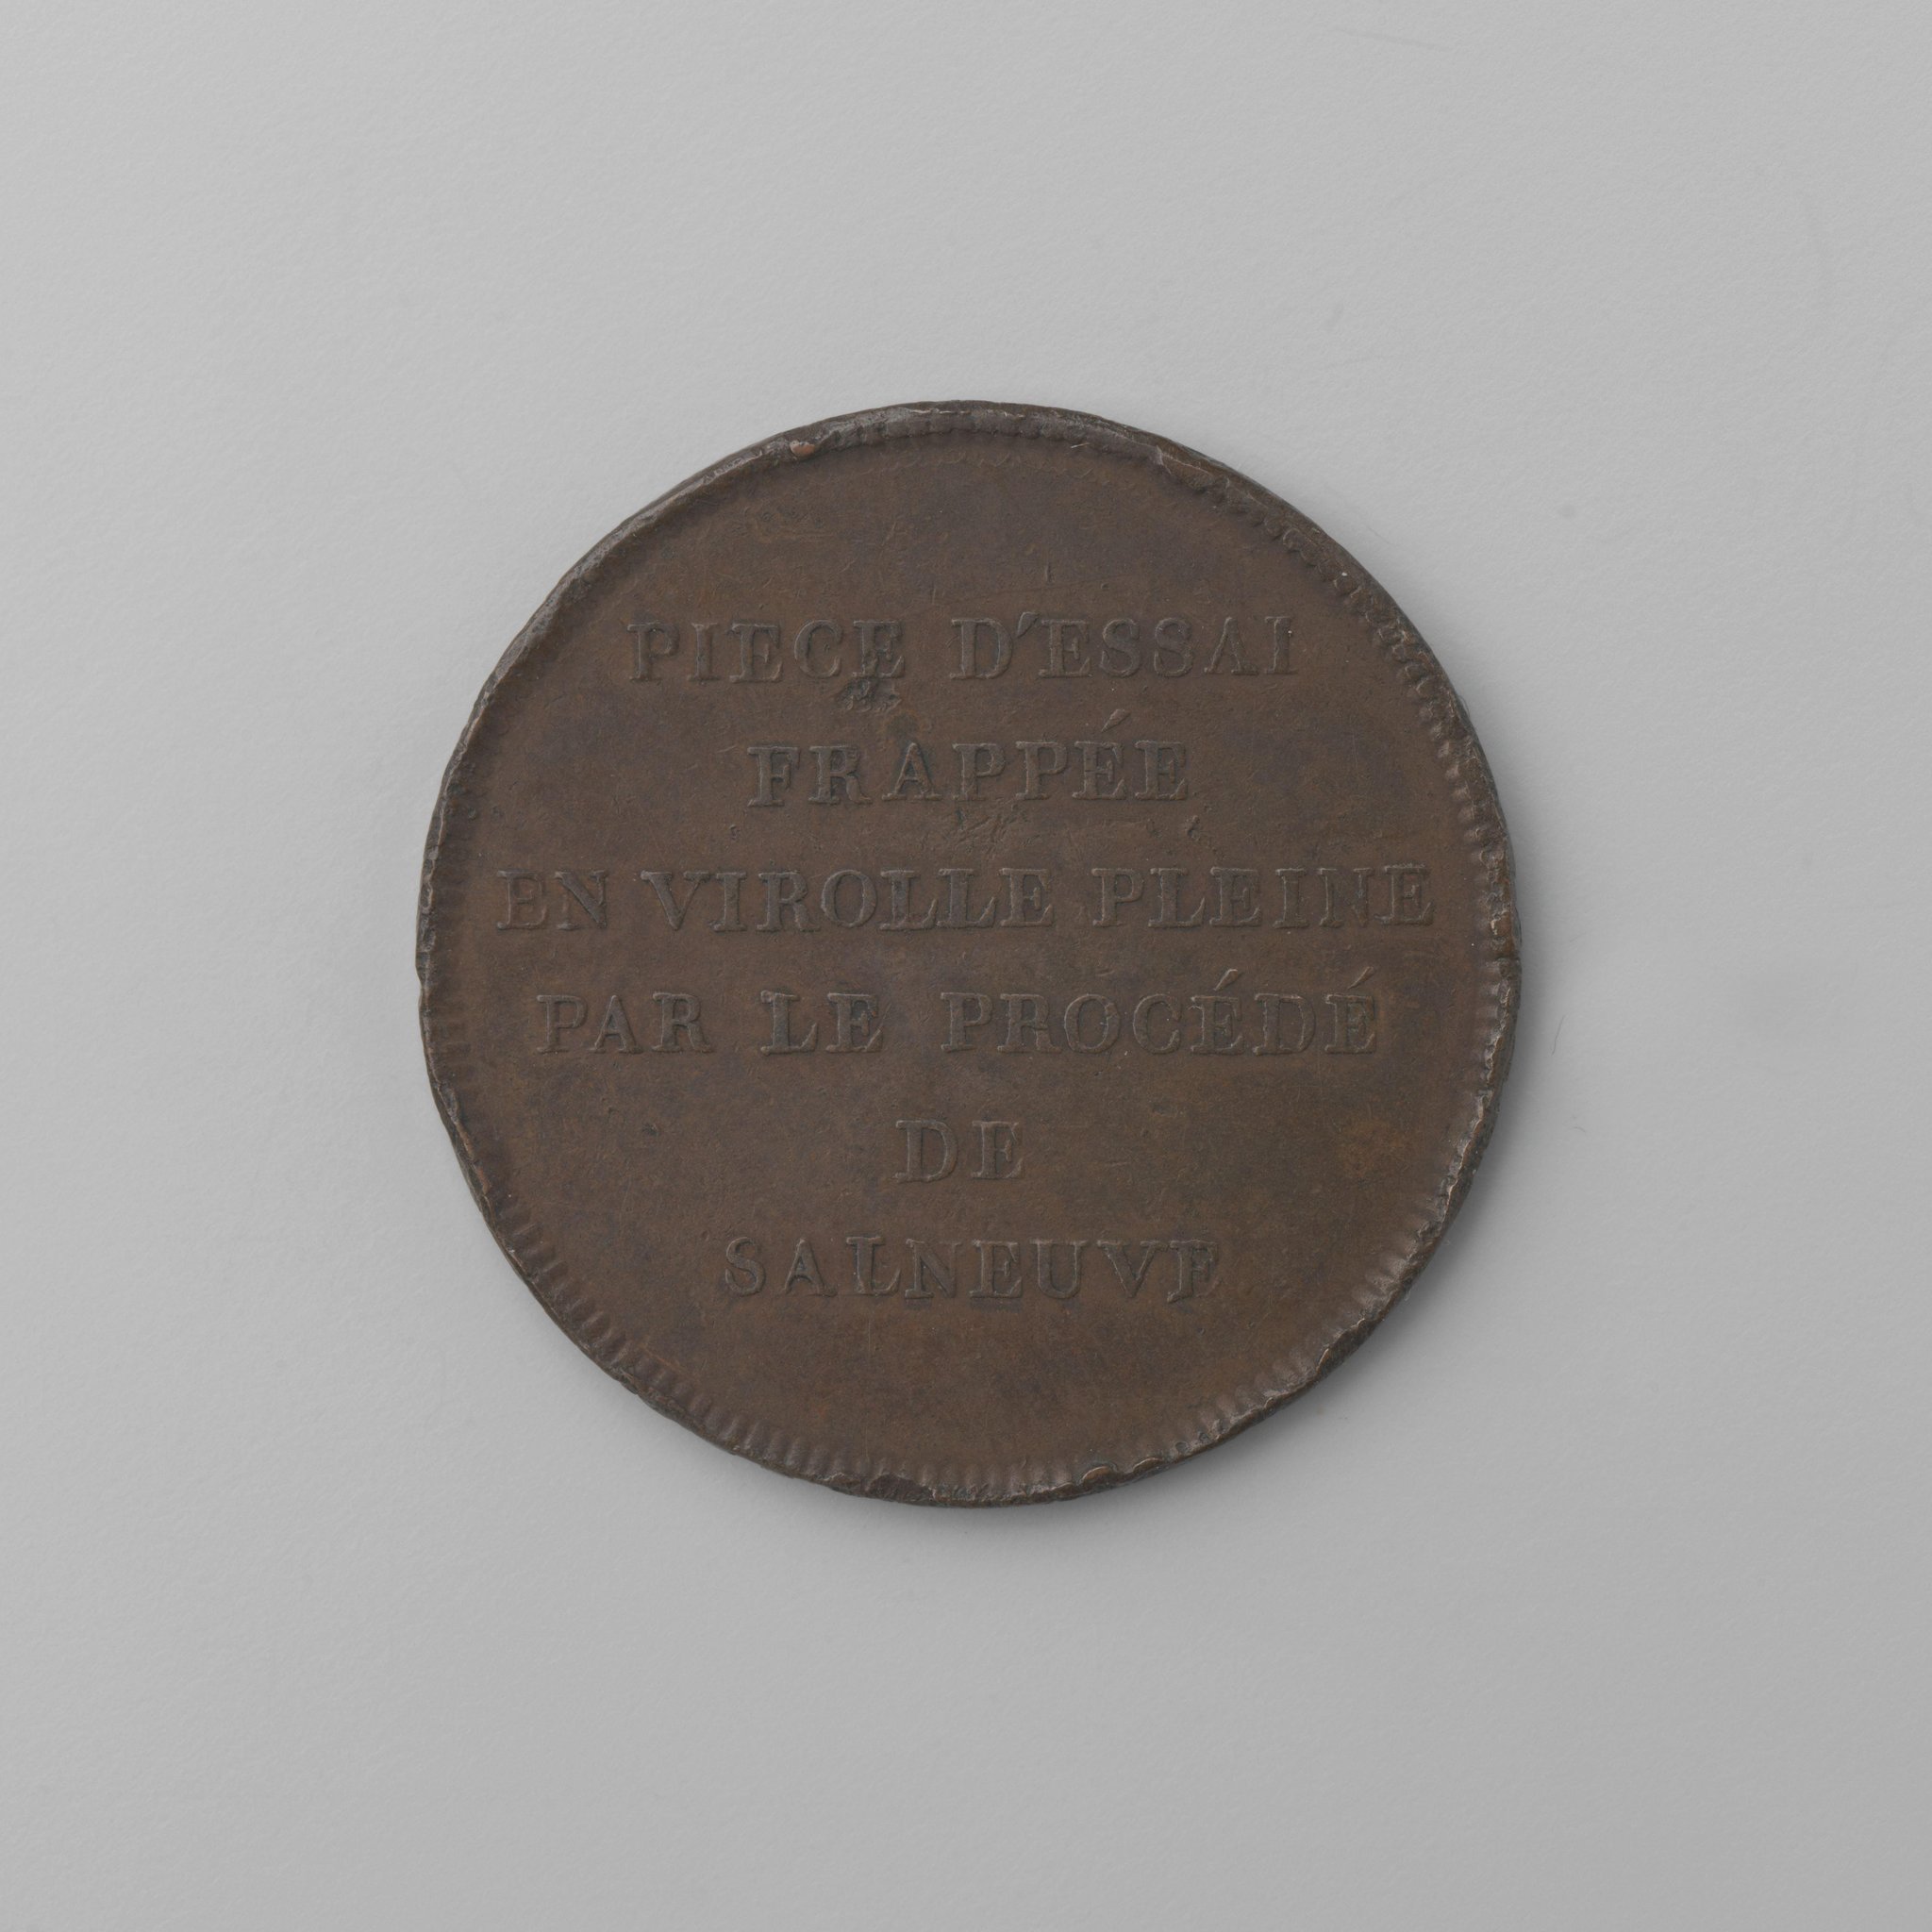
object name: coin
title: Koninkrijk Holland, gulden, 1808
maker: louis napoleon (king of holland)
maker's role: koning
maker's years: 1778-1846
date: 1808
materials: bronze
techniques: striking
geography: utrecht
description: Bronzen munt. Voorzijde: zes-regelig opschrift met naam Salneuve. Keerzijde: zes-regelig opschrift, waaronder jaartal. Randschrift. Proefslag in brons ter grootte van gulden met randschrift volgens het systeem van Salneuve.